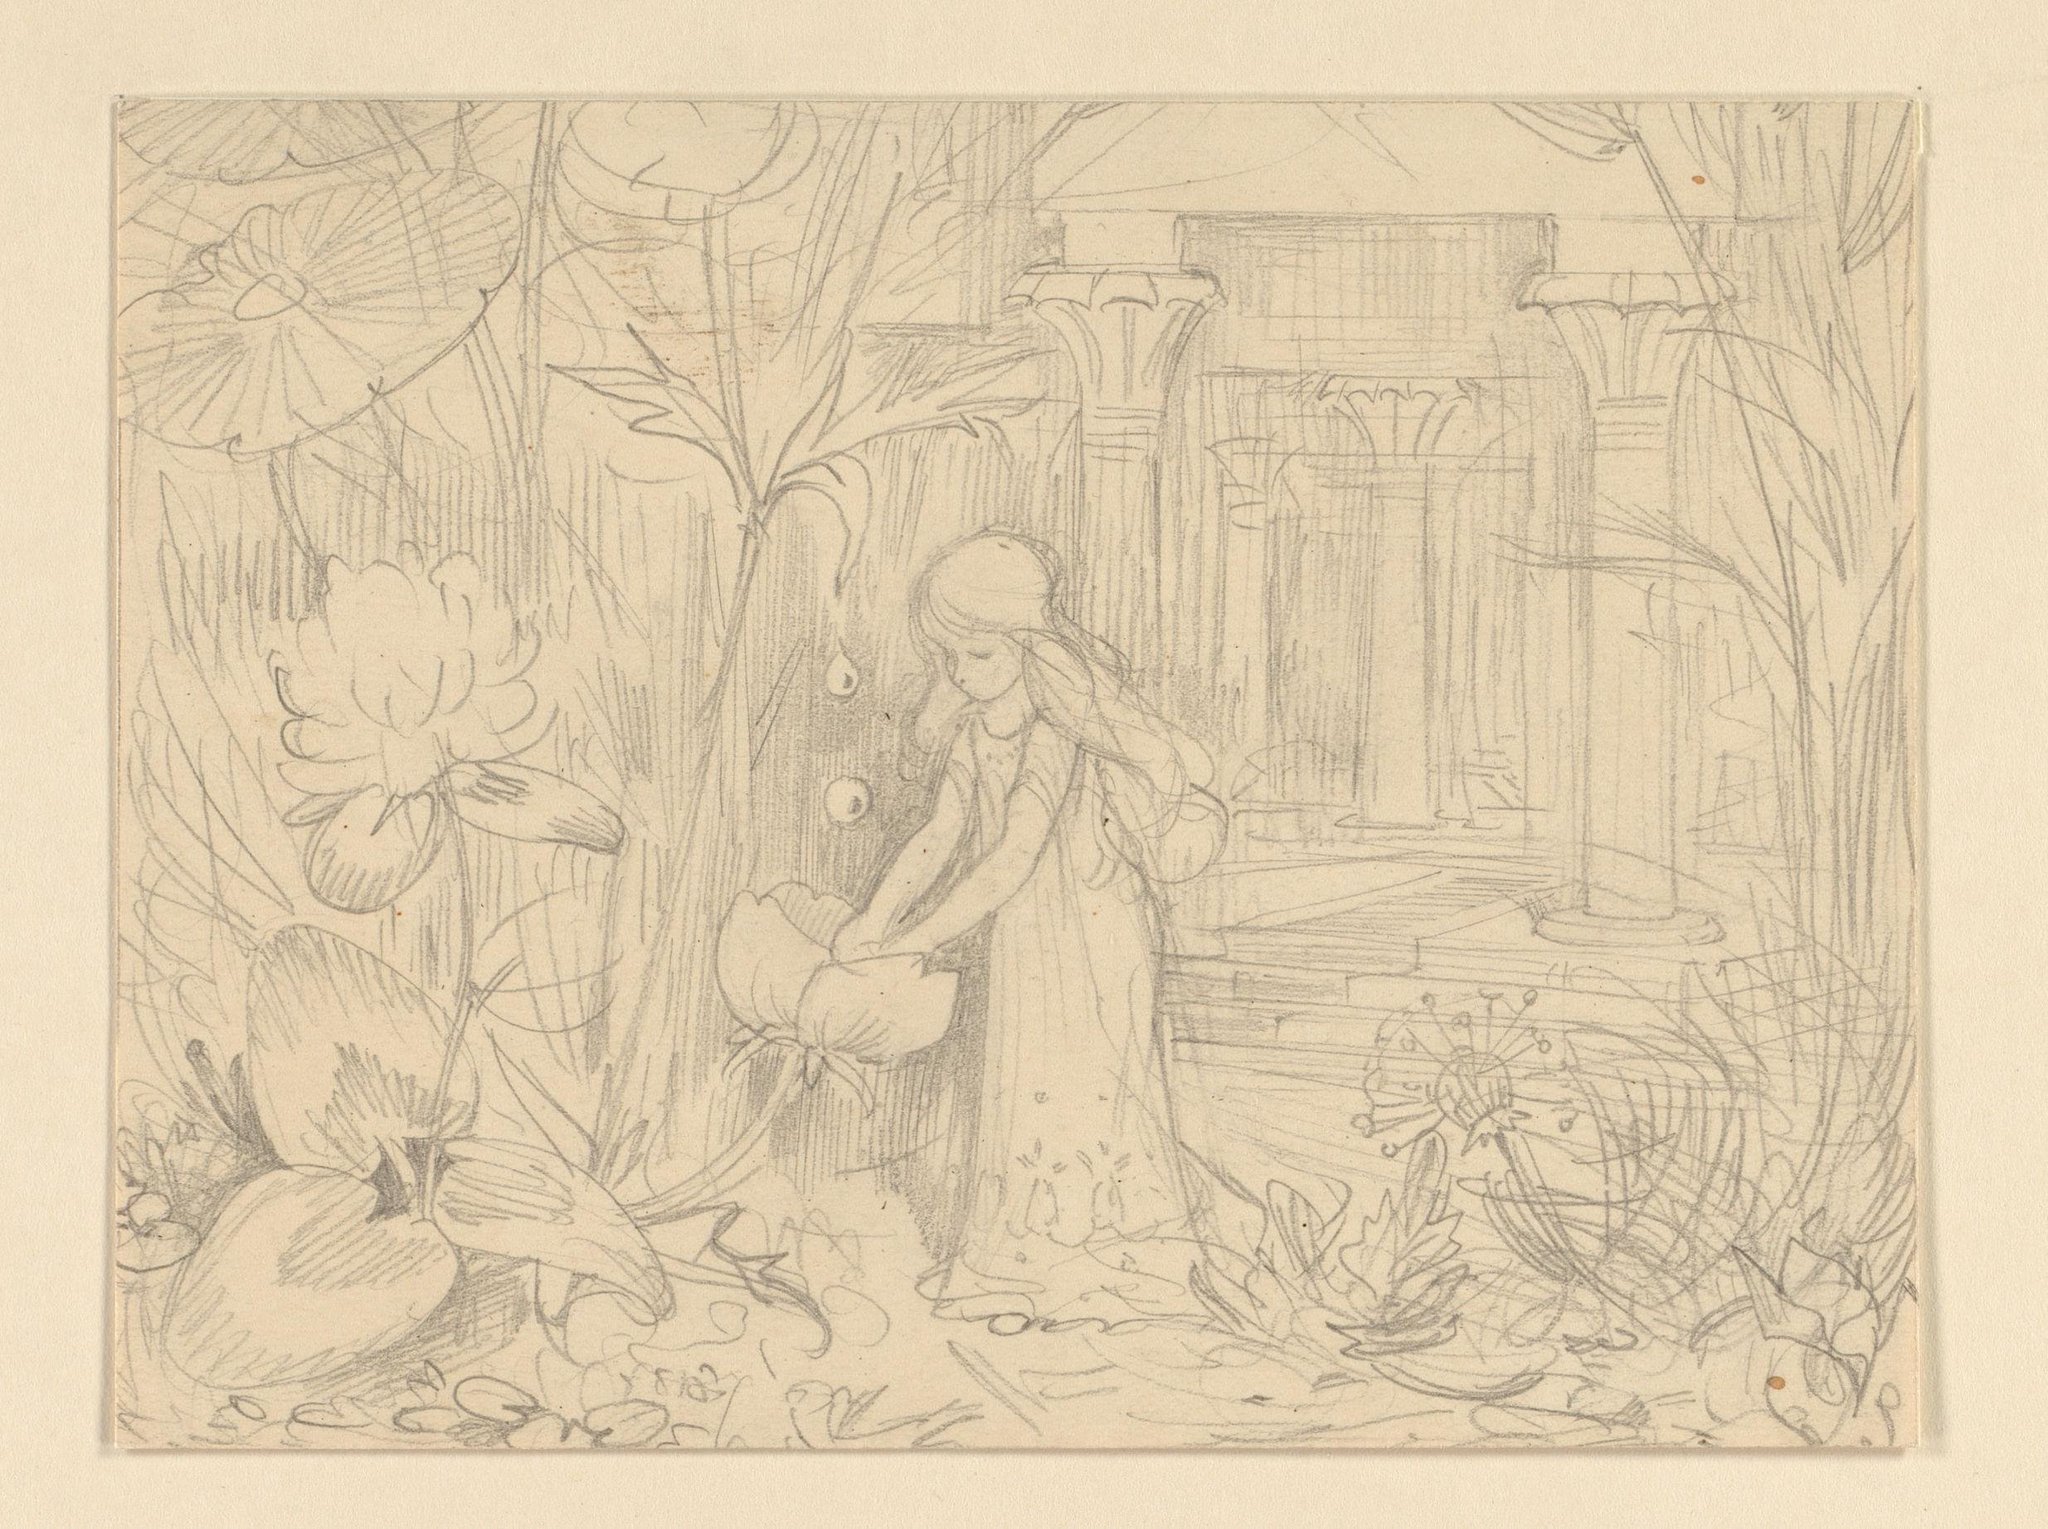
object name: drawing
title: De Grasprinses omringd door bloemen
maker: edzard koning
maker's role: draughtsman, print maker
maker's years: 1869-1954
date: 1903-1931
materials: cardboard, pencil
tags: flowers, (koning, de grasprinses) specific works of literature (with author, title), princess, tales and fairy tales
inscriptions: number: ‘1.’, collector's mark: Lugt 2228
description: Ontwerp voor het niet uitgegeven sprookje: Koning, Edzard. De Grasprinses. Bussum: C.A.J. van Dishoeck, s.a.